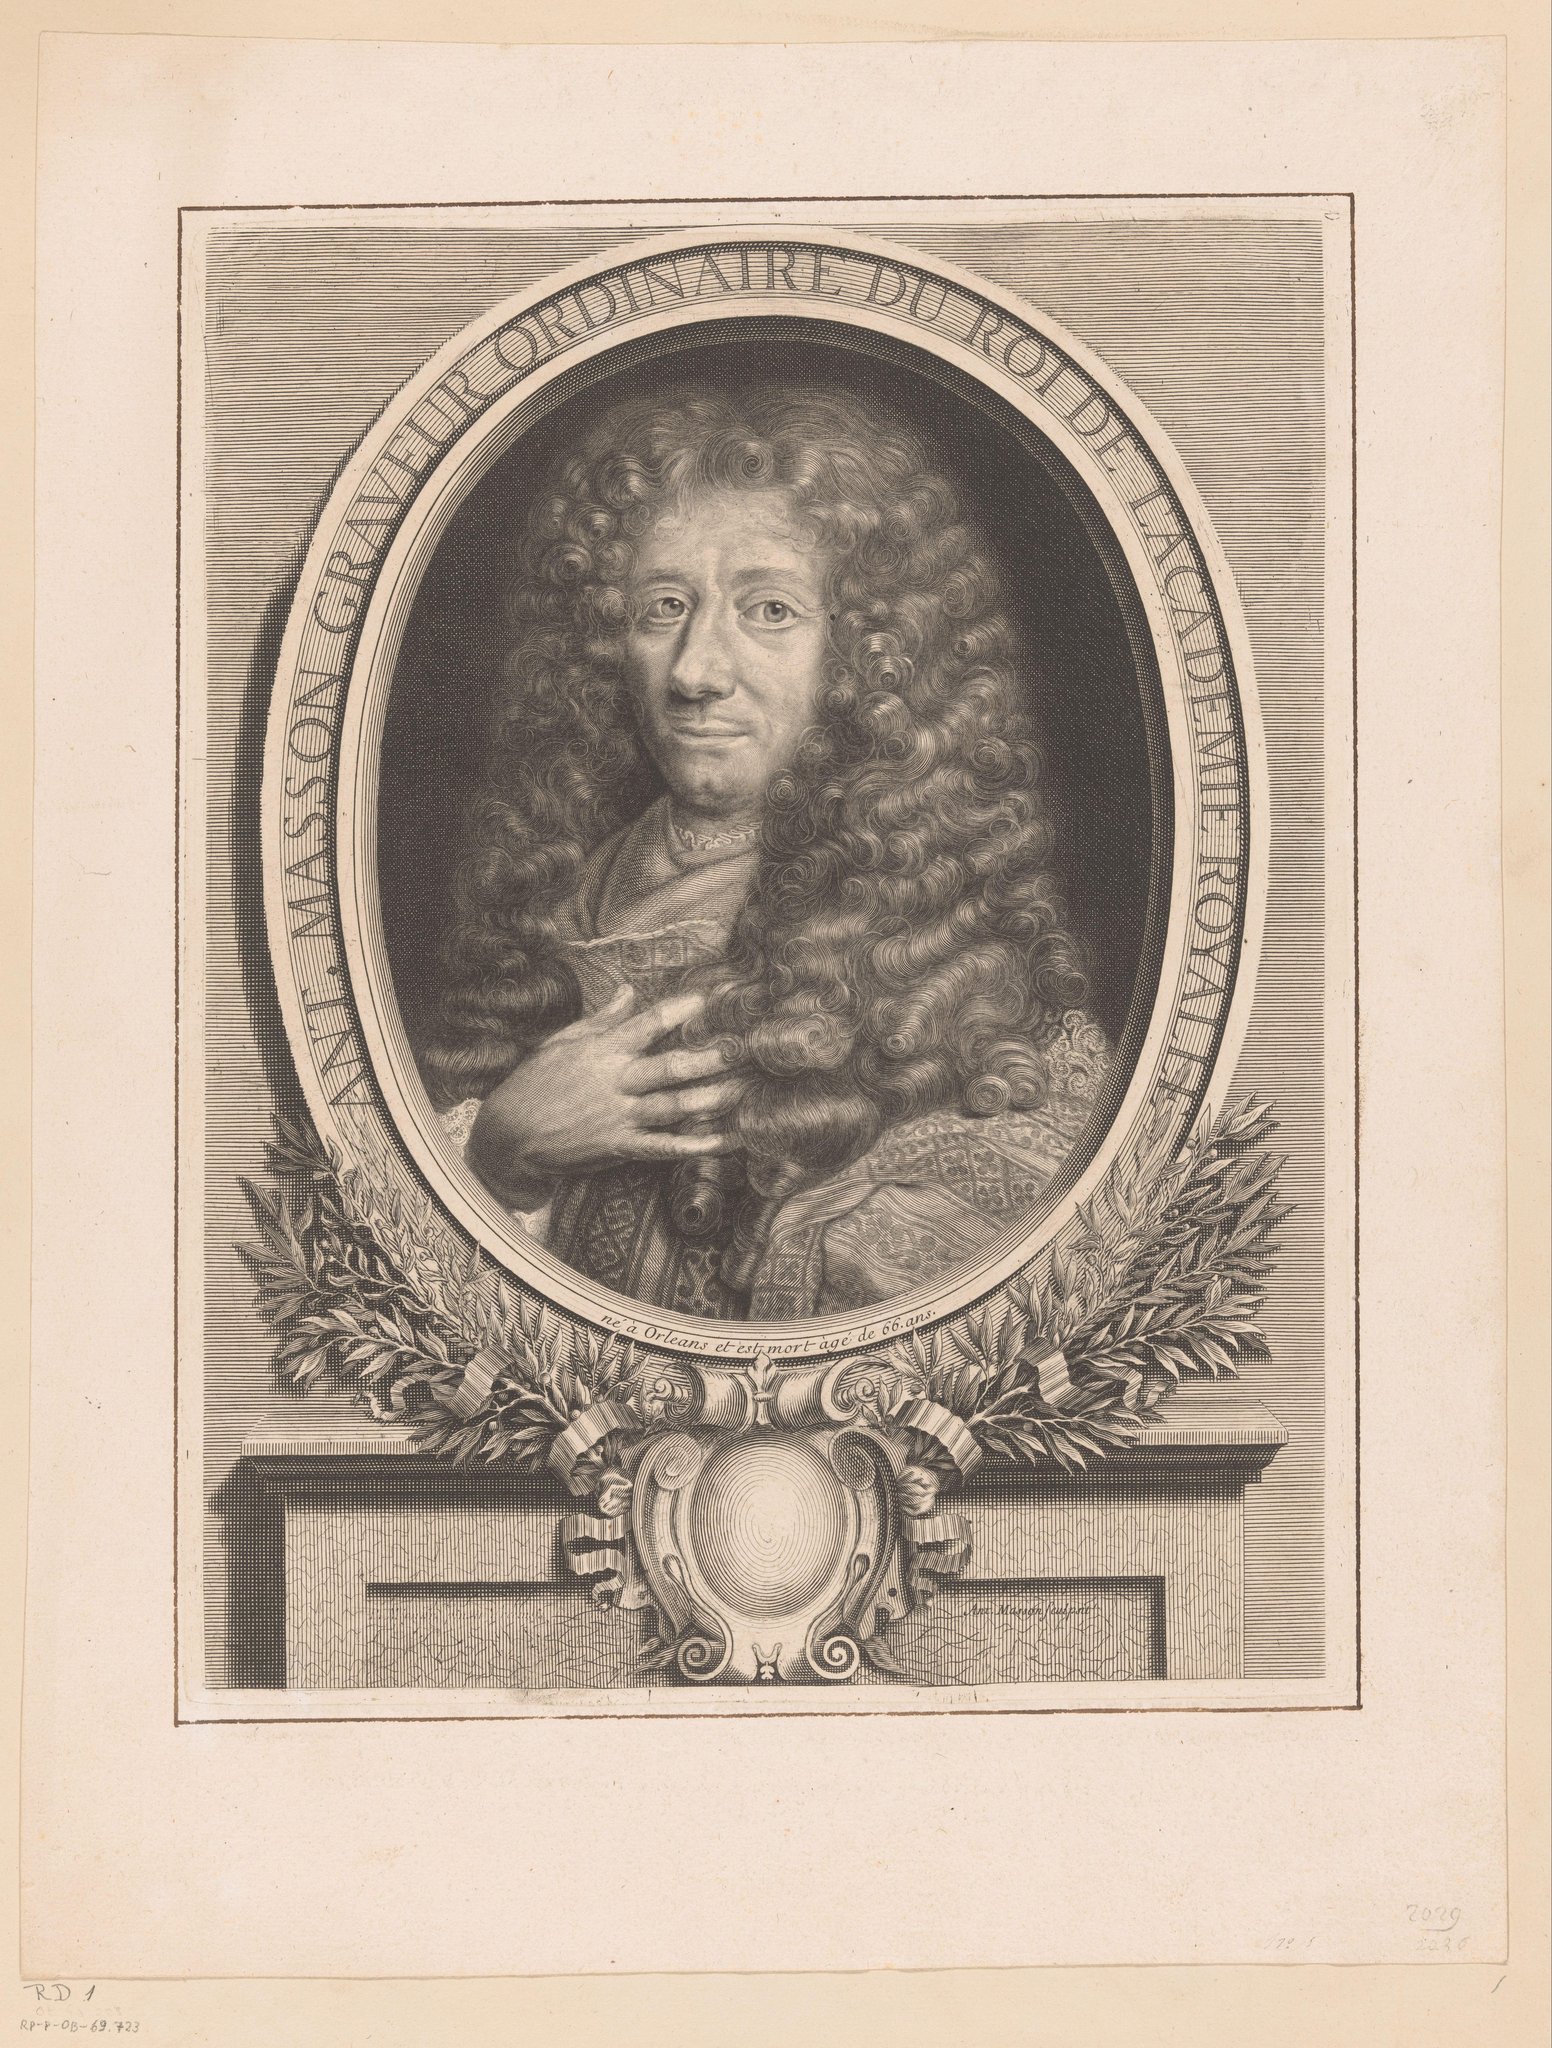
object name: print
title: Portret van Antoine Masson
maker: antoine masson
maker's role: print maker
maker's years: 1636-1700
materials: paper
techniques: engraving, etching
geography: france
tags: paris, print maker, antoine masson, historical persons, portrait, self-portrait of graphic artist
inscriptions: collector's mark: Lugt 240